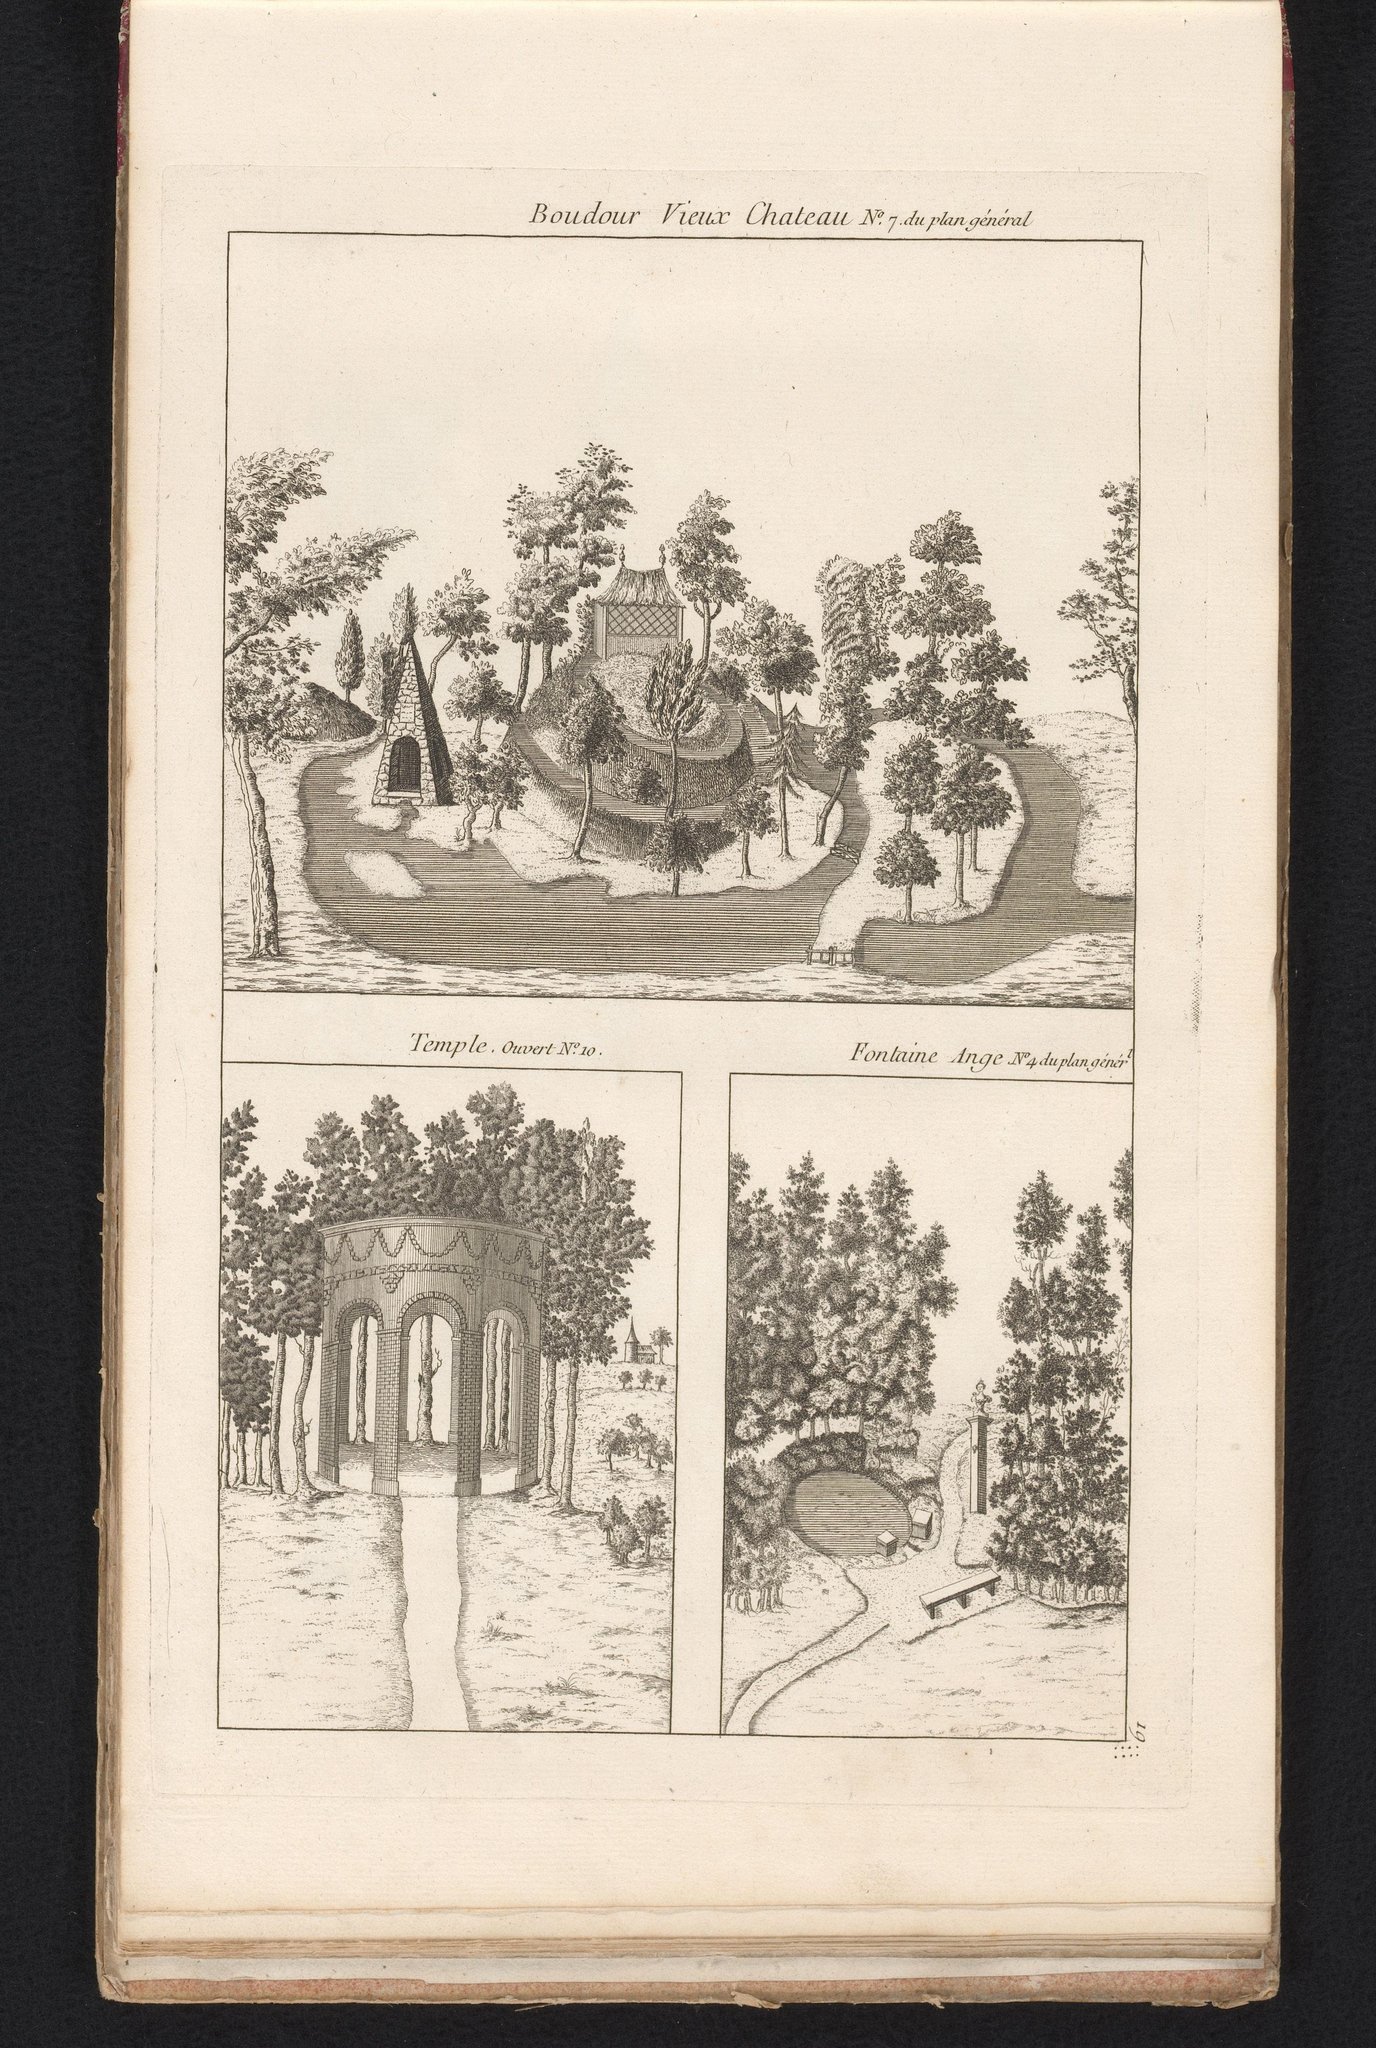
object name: print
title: Boudour vieux chateau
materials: paper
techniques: engraving, etching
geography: paris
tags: ruins (garden ornaments), water-works in garden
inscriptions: collector's mark: Lugt 2760, collector's mark: Lugt 2228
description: De serie 'Jardins anglo-chinois à la mode' verscheen in totaal in 21 zogeheten 'cahiers' (afleveringen). De huidige prent komt uit het achtste 'cahier'. Het Rijksmuseum Amsterdam bezit drie banden met daarin in totaal zes 'cahiers' van deze reeks. In de documentatie wordt verwezen naar een in de bibliotheek van het Rijksmuseum Amsterdam aanwezige facsimile van het complete werk.